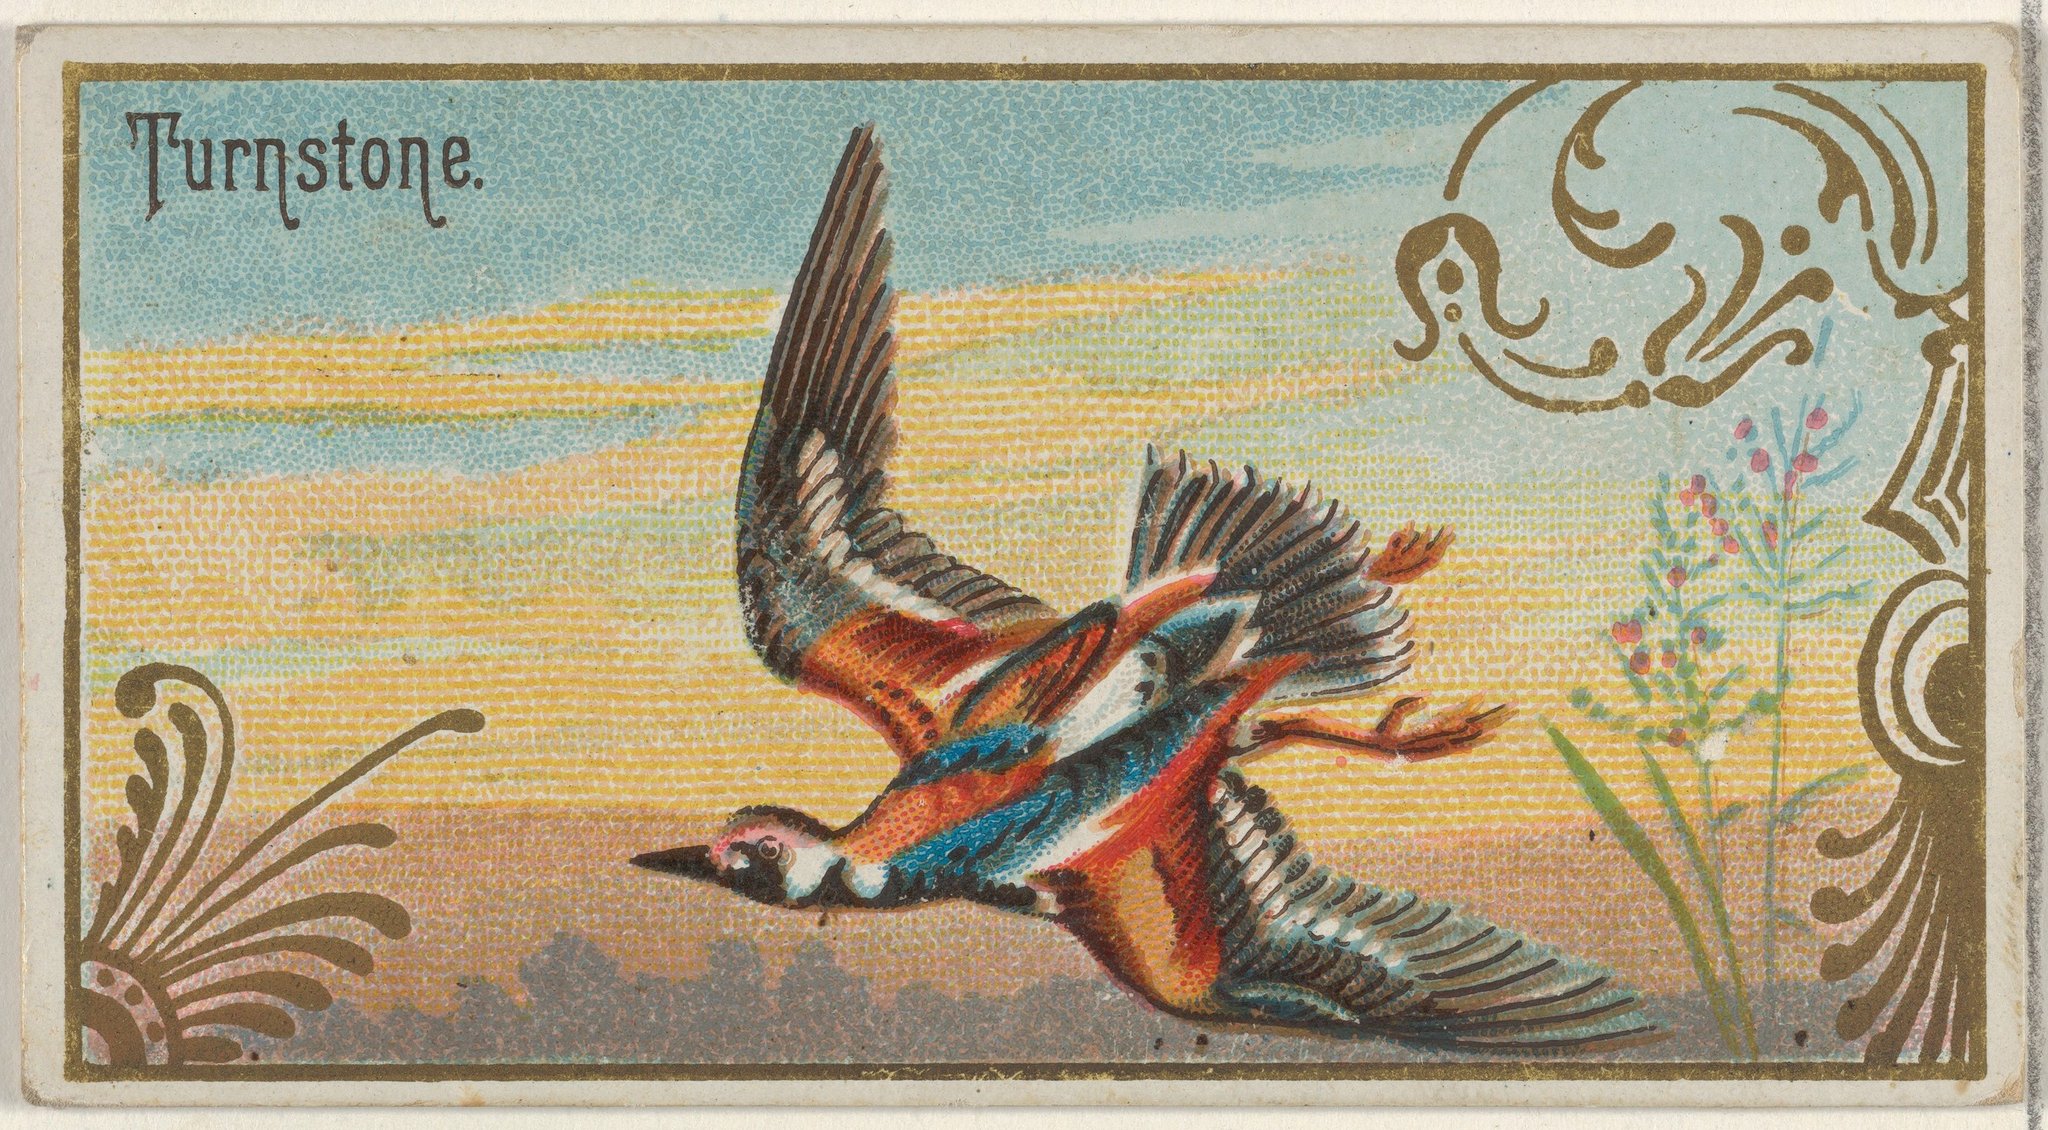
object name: print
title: Turnstone, from the Game Birds series (N13) for Allen & Ginter Cigarettes Brands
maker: allen & ginter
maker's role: publisher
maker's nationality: american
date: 1889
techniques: color lithograph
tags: birds